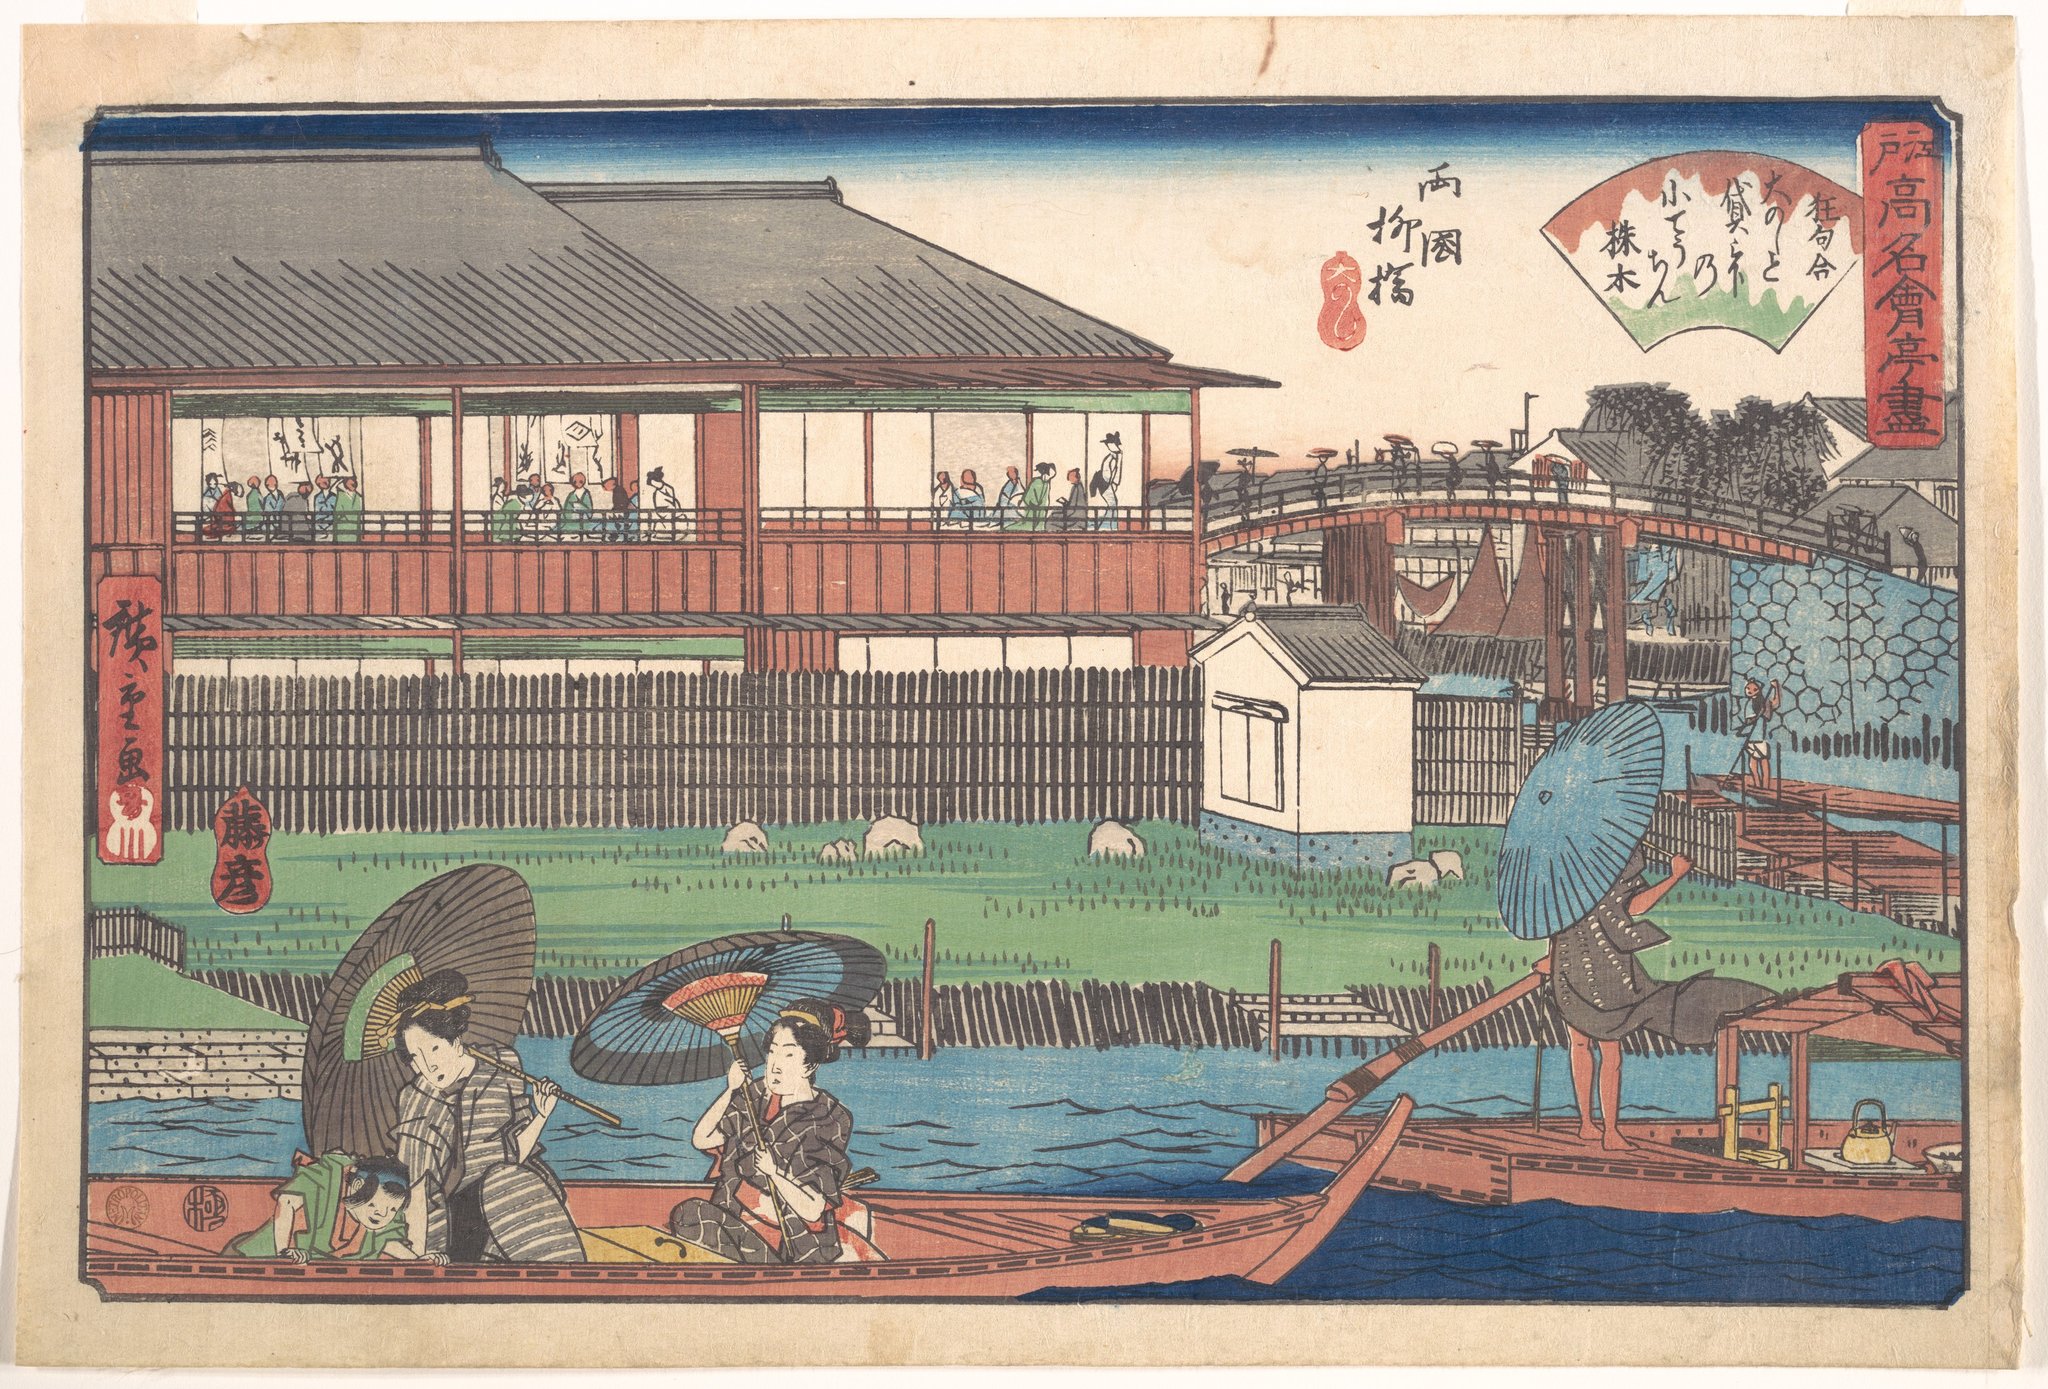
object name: print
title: The Ono at Ryogoku Yanagibashi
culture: japanese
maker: utagawa hiroshige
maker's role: artist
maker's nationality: japanese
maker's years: 1797-1858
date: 1835-1842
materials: ink, paper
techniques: woodblock print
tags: bridges,women,boats,tea houses